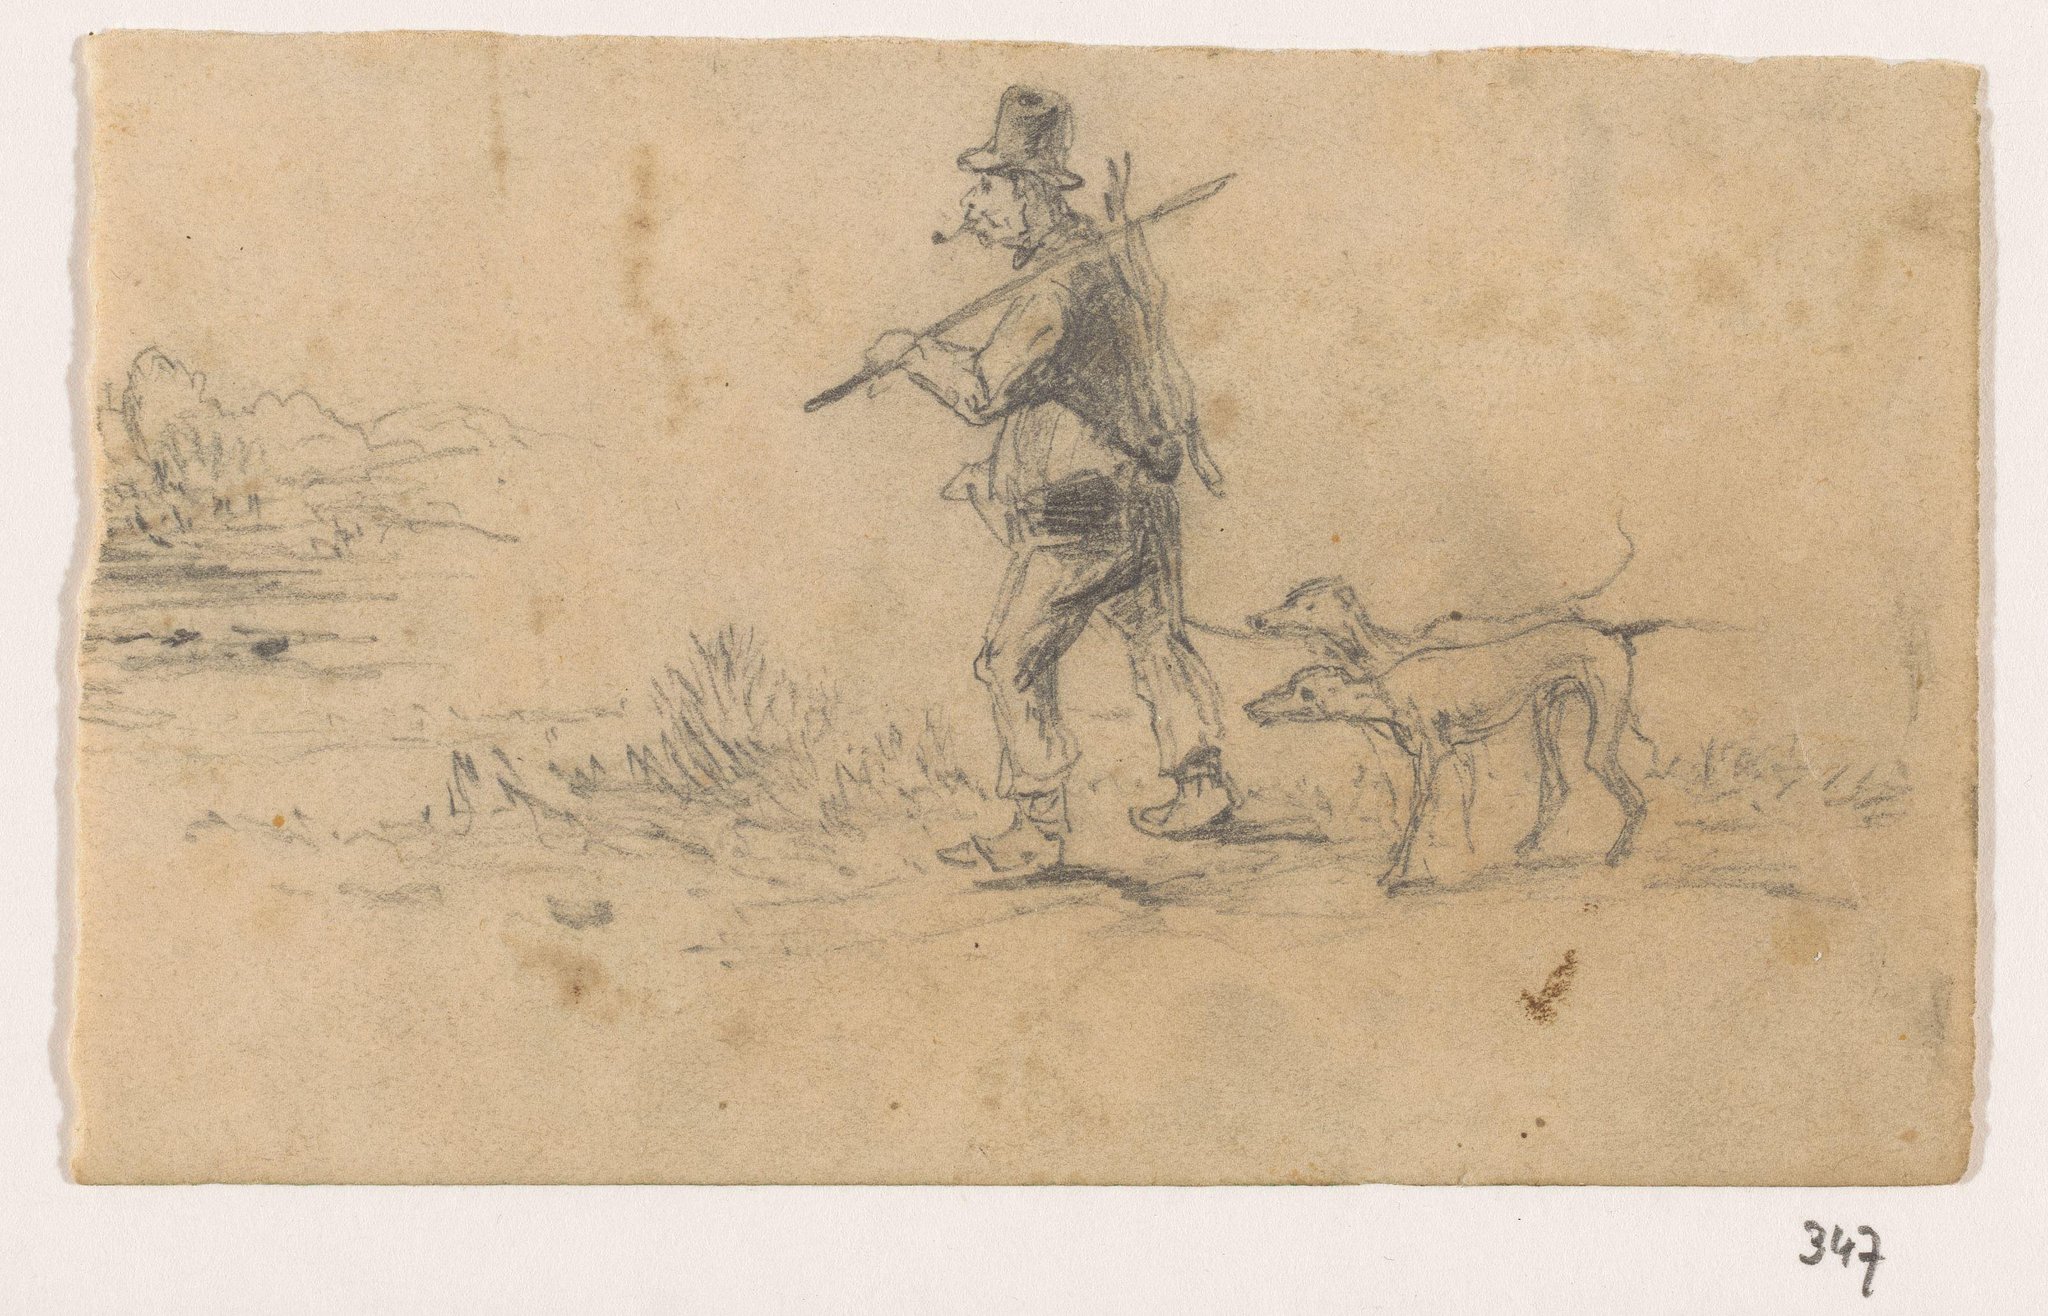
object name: drawing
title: Jager met honden en een haas op de rug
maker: johannes tavenraat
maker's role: draughtsman, painter, print maker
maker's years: 1809-1881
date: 1840-1880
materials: paper, pencil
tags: return from the hunt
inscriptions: collector's mark: Lugt 2228, signature: ‘JT’